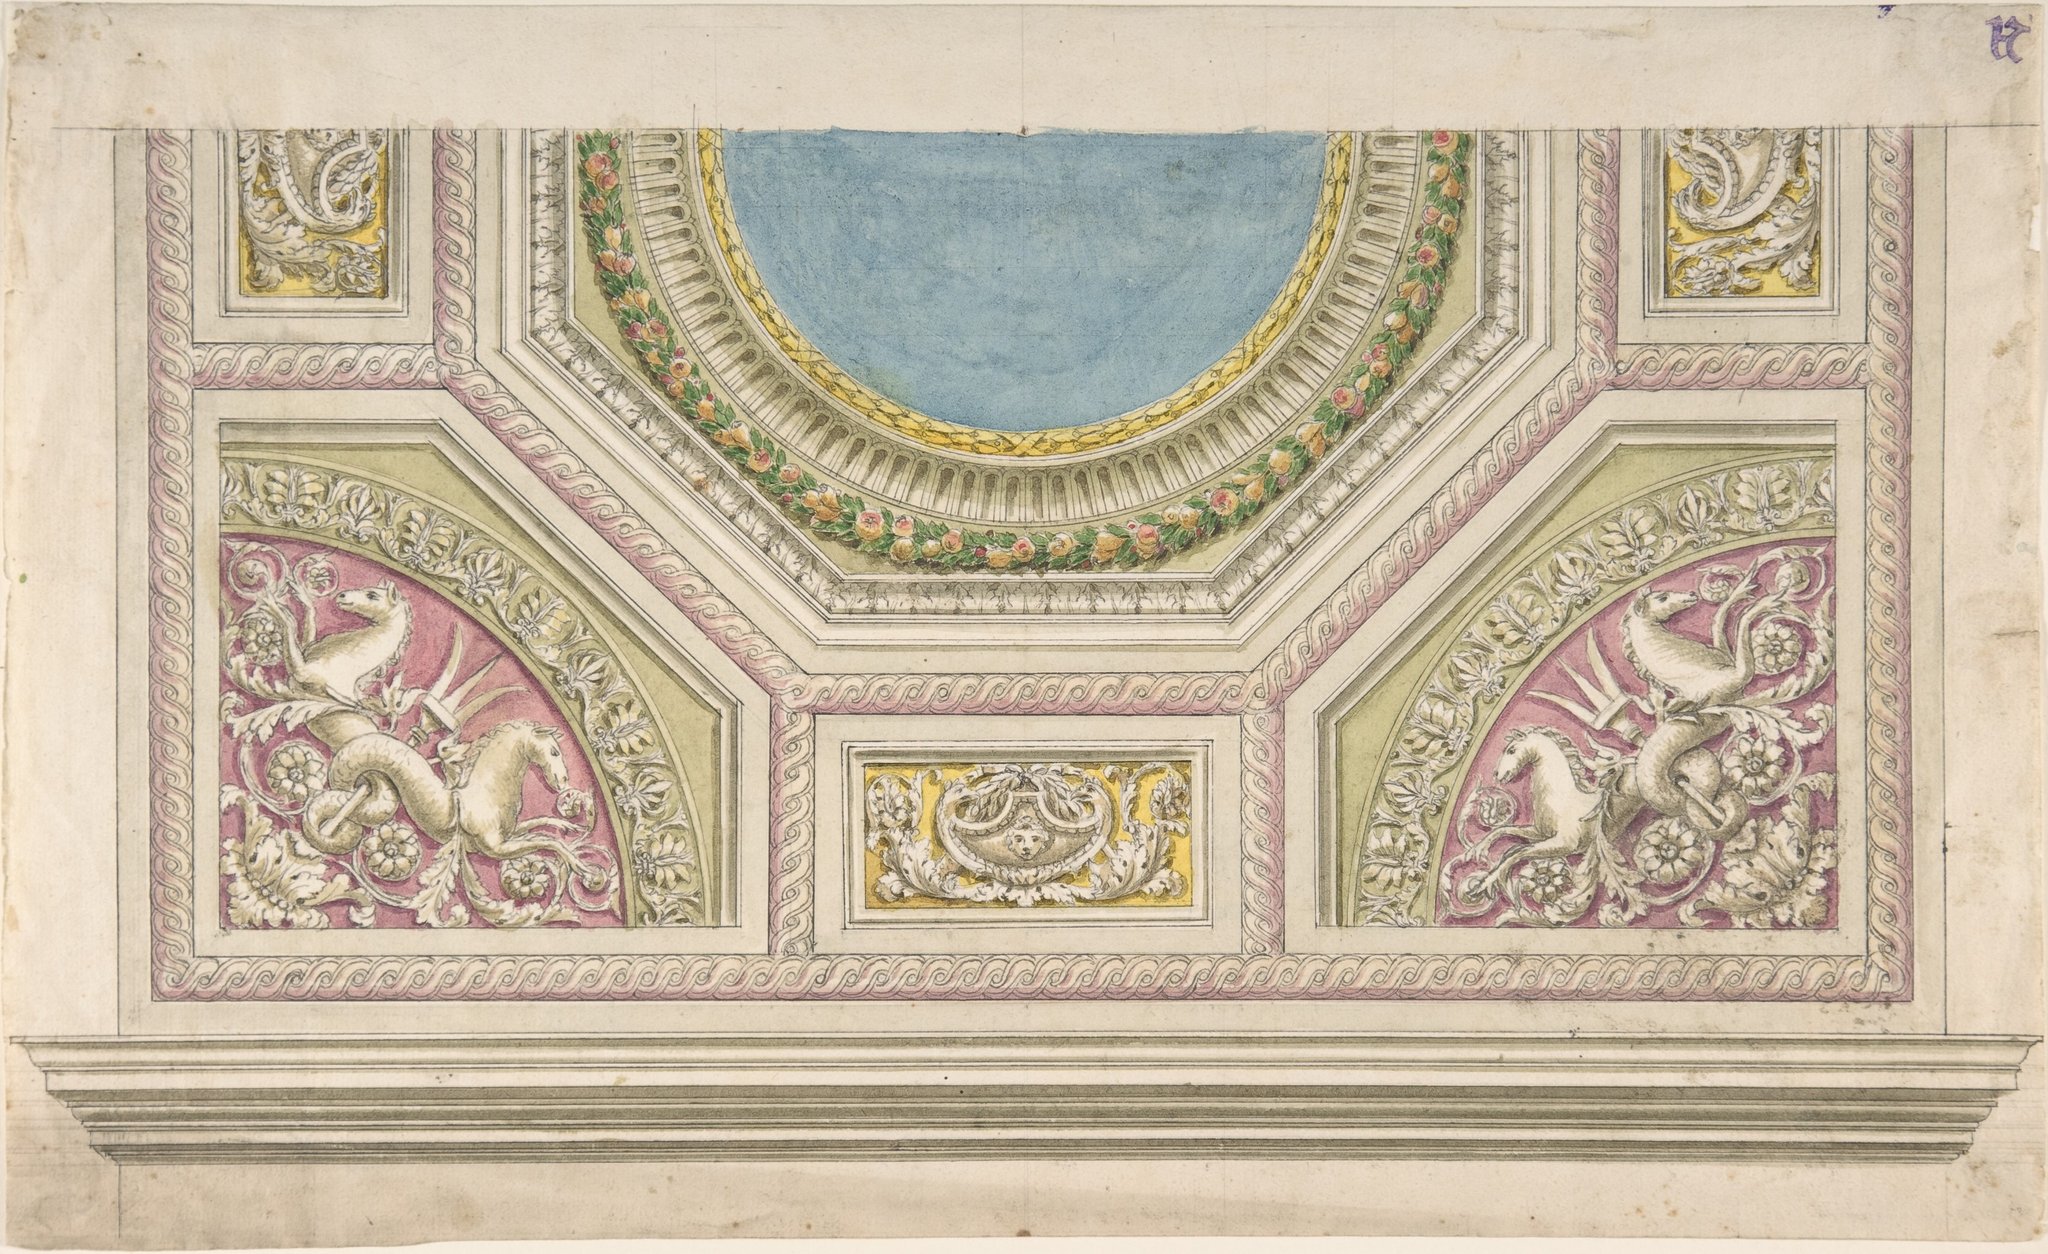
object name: drawing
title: Design for a Decorated Ceiling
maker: anonymous, italian, 19th century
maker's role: artist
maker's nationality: italian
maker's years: 1800-1900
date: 1801-1900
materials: watercolor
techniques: pen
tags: flowers